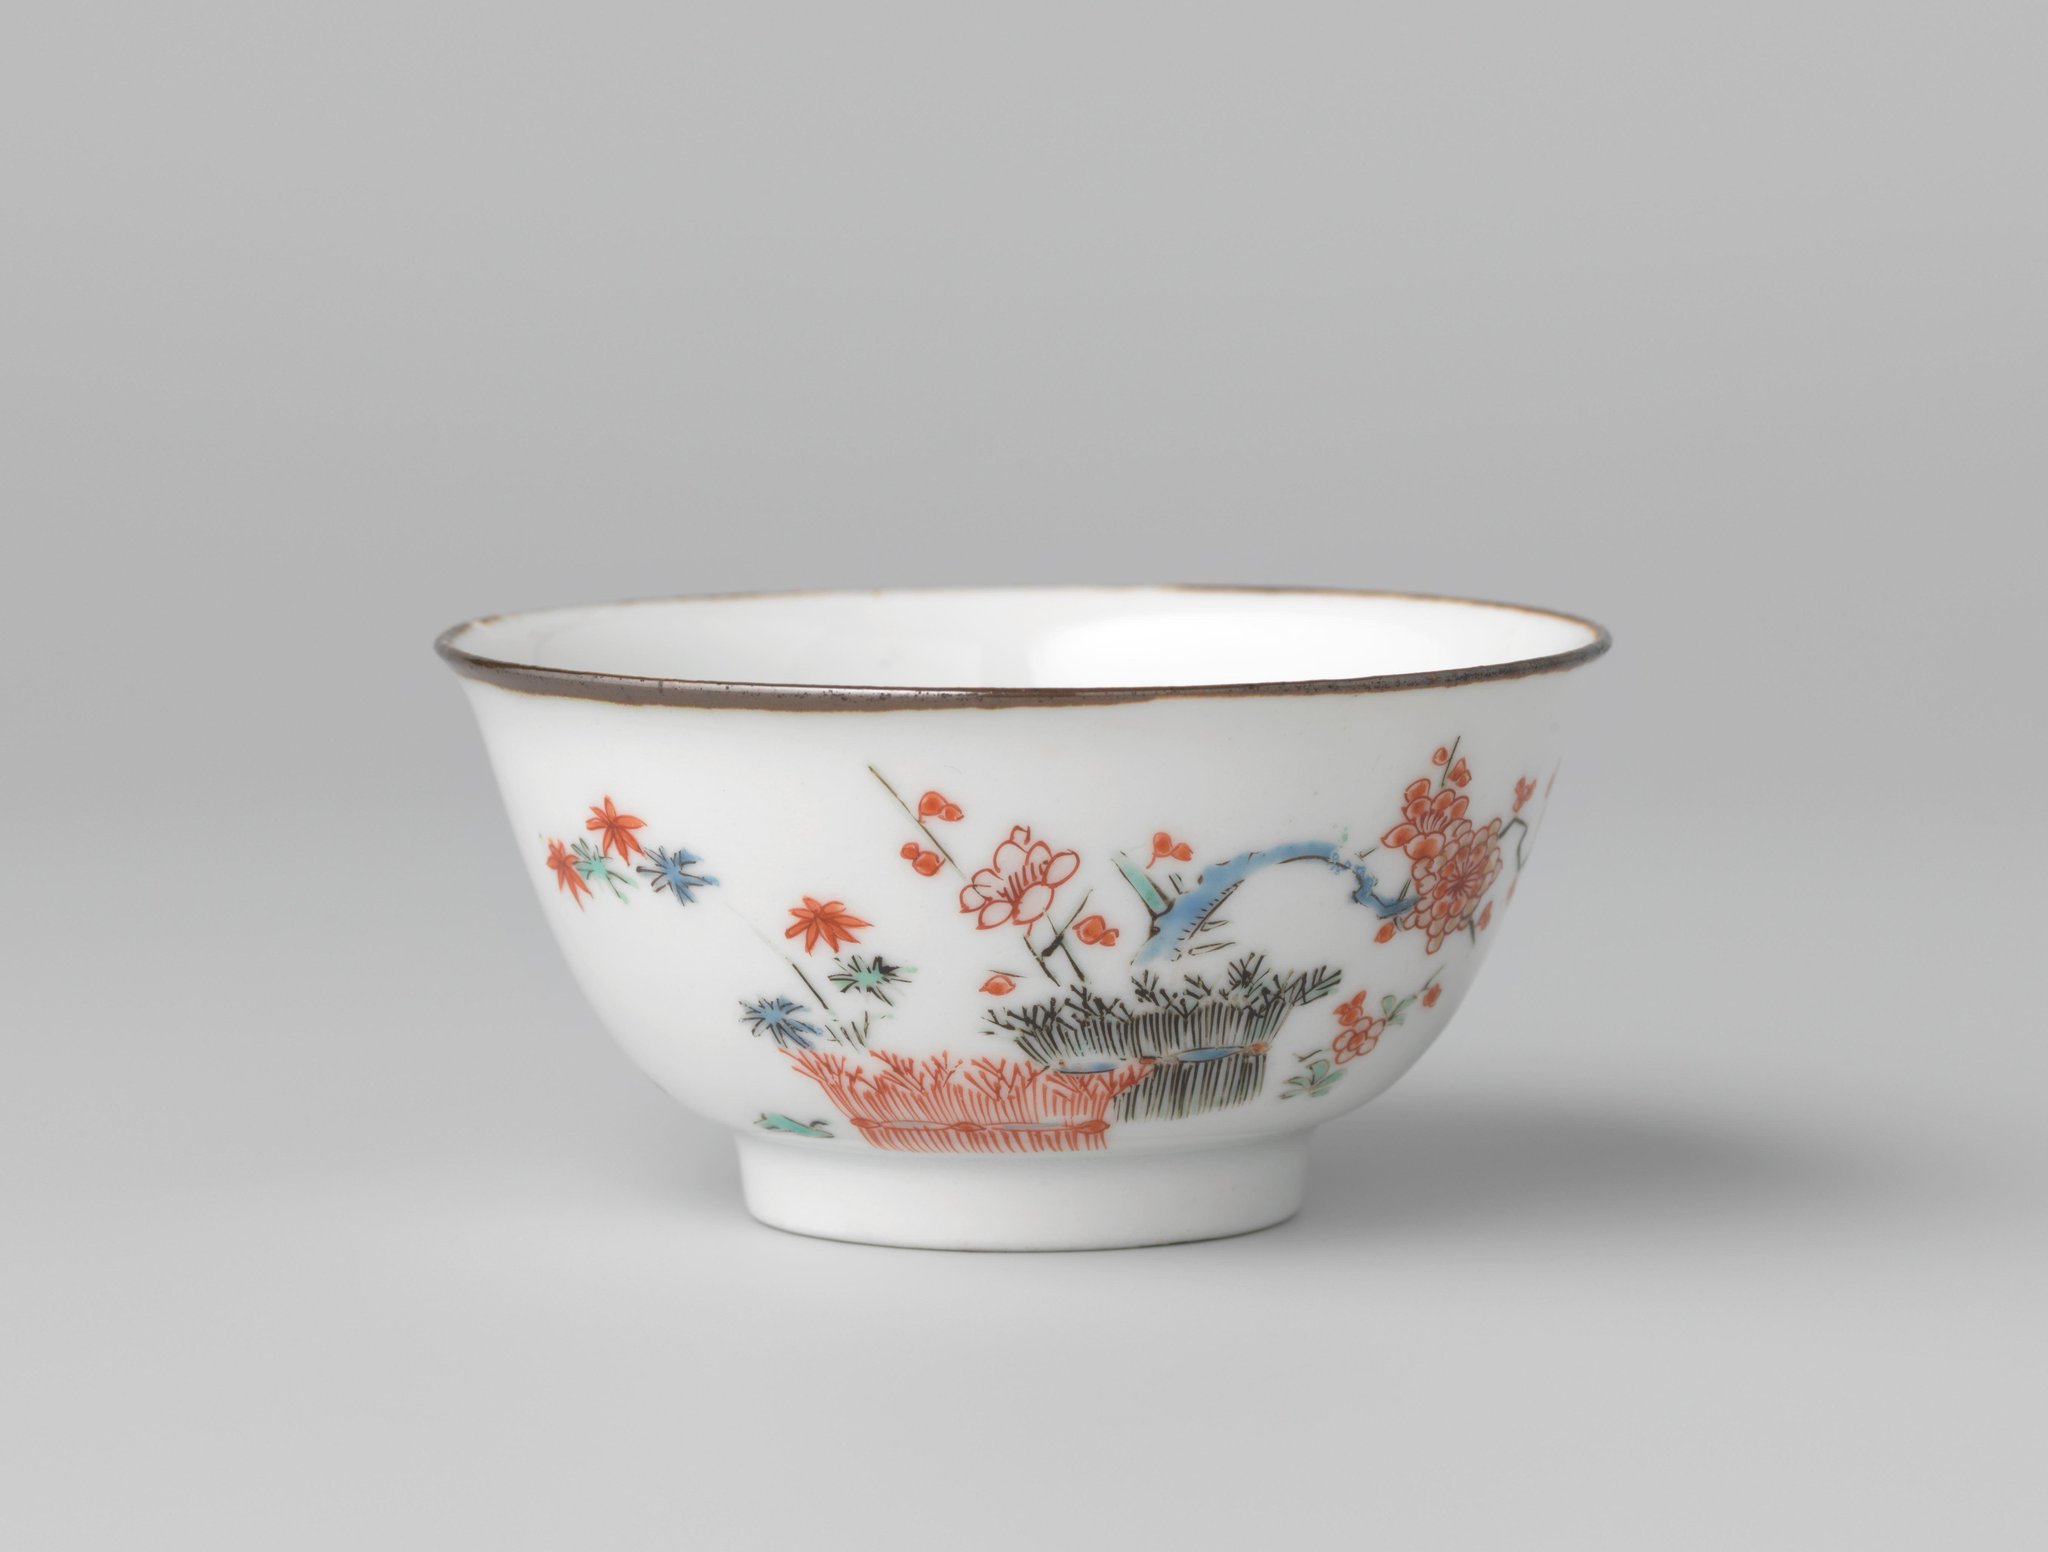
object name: cup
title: Cup with hedges, bamboo, prunus and hoo-bird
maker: Anonymous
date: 1670-1690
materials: glaze, gold, paint, porcelain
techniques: firing, gilding, turning, vitrification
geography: japan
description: Kop van porselein, beschilderd op het glazuur in blauw, rood, groen, geel, zwart en goud met bamboe, prunus en nog een plant bij gebonden heggen, en een hoo-vogel. Bruine rand. Een chip in de rand. Kakiemon.